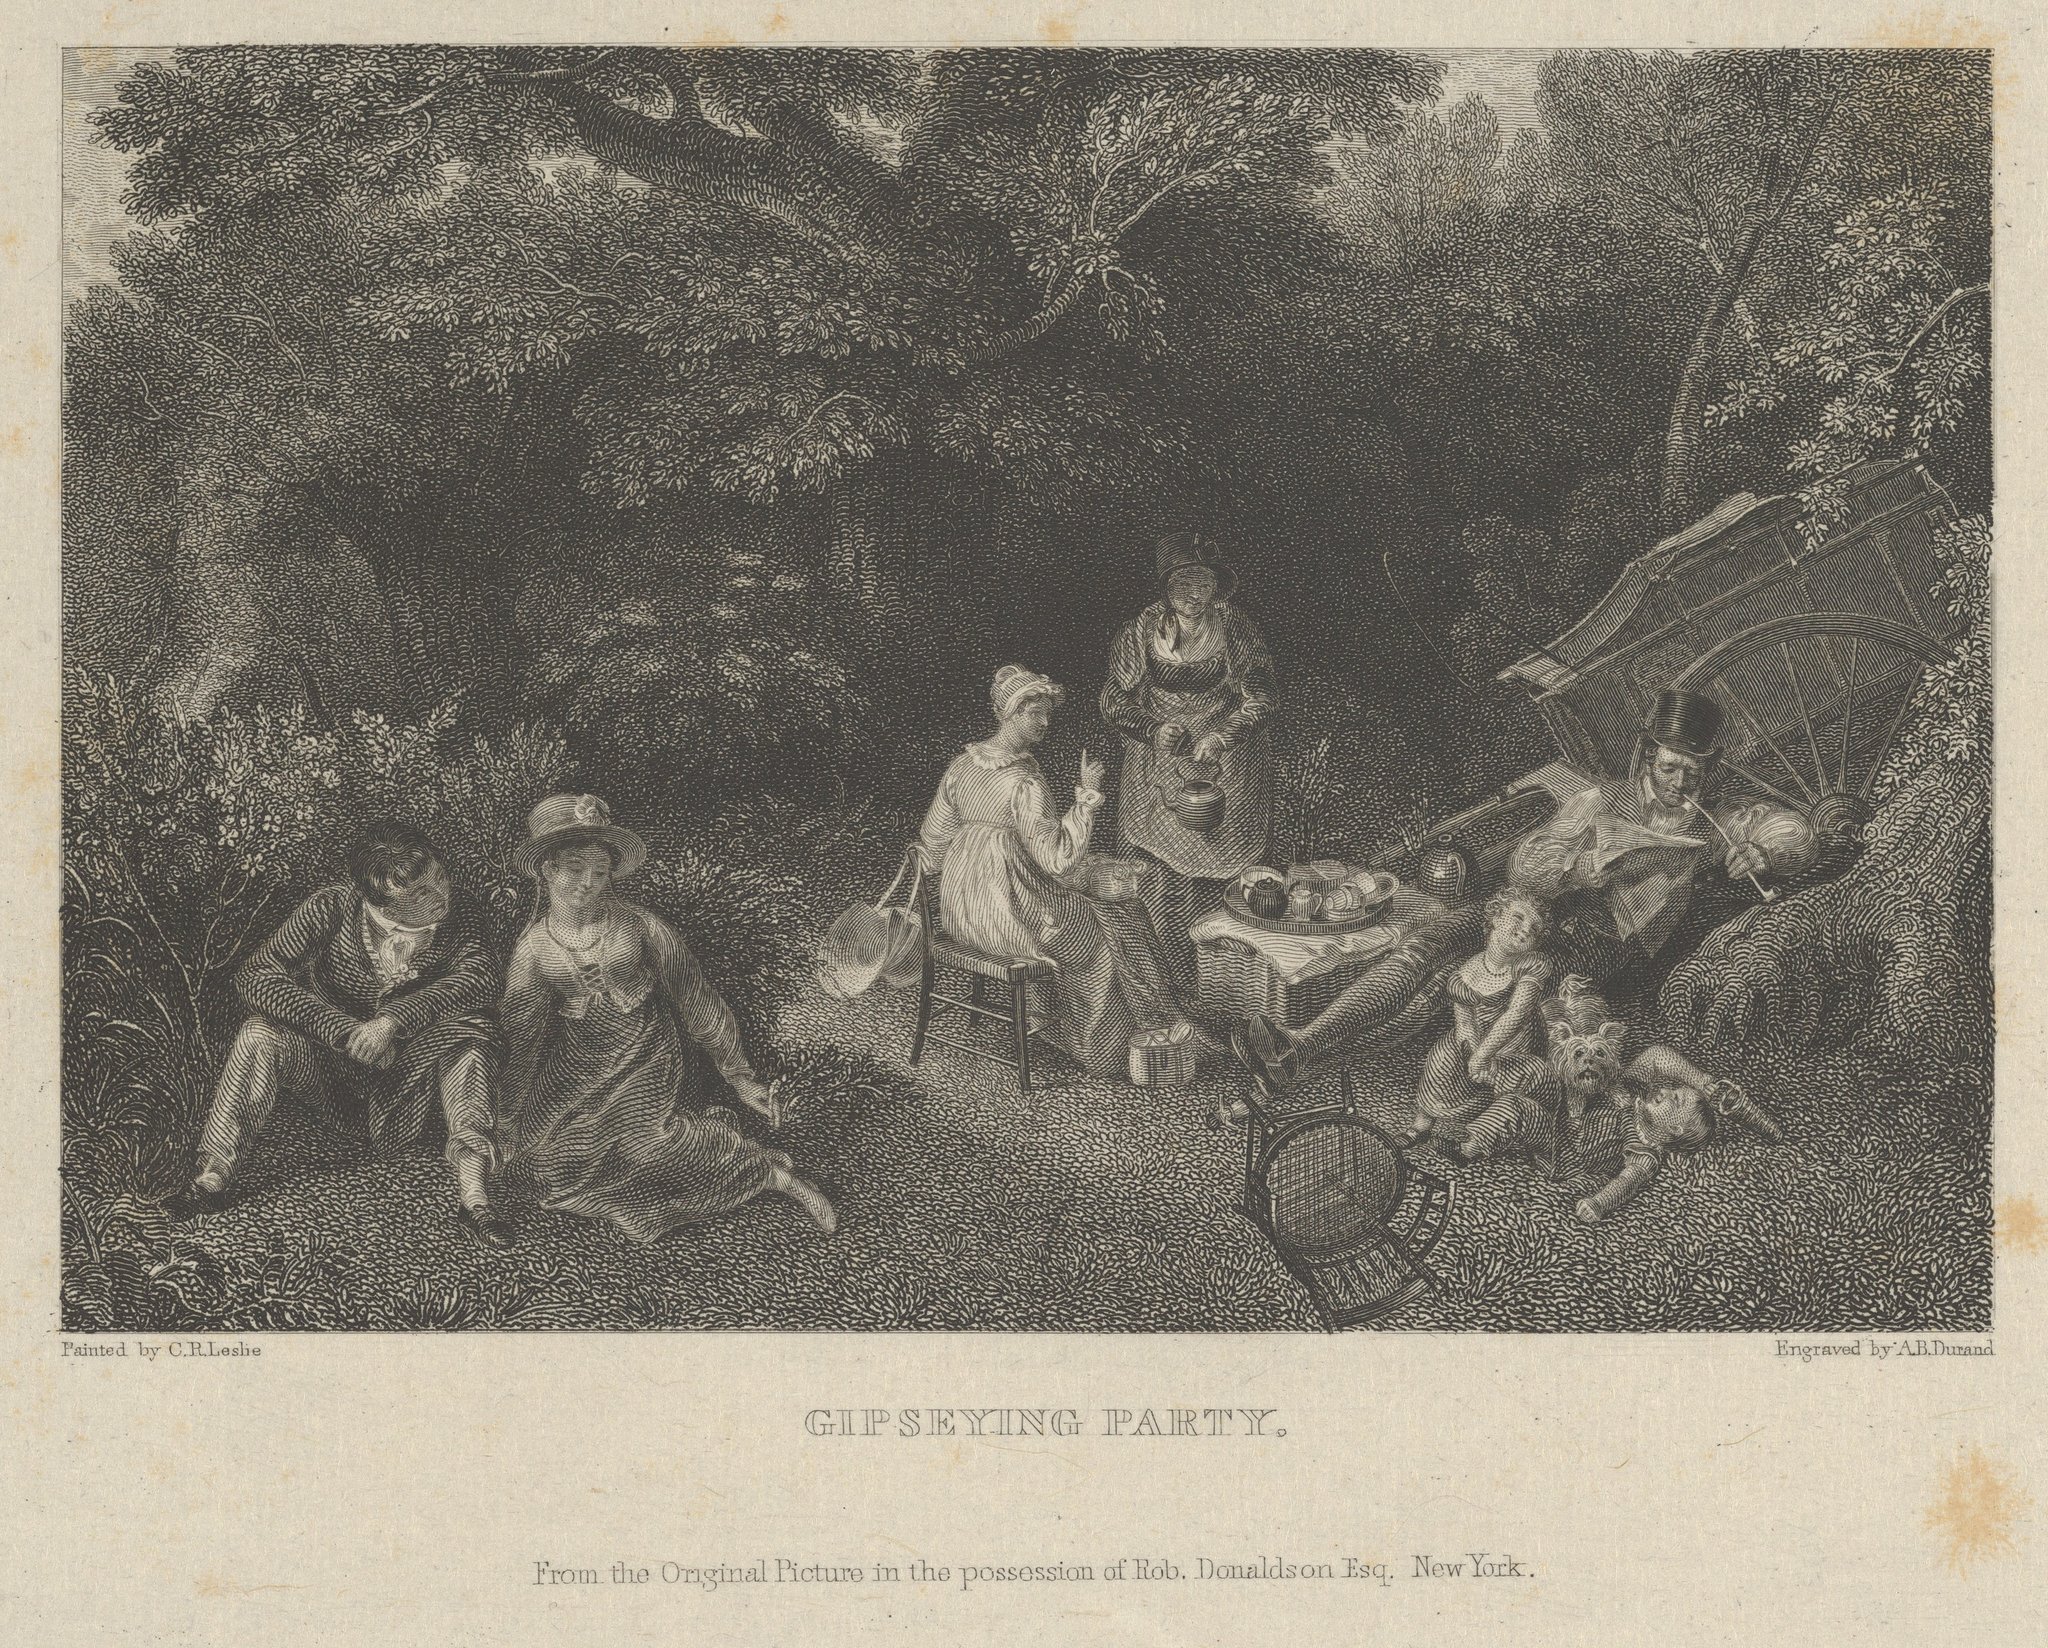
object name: print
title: Gipseying Party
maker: asher brown durand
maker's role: artist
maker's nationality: american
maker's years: 1796-1886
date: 1830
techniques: printmaking, engraving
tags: boys,girls,men,women,party